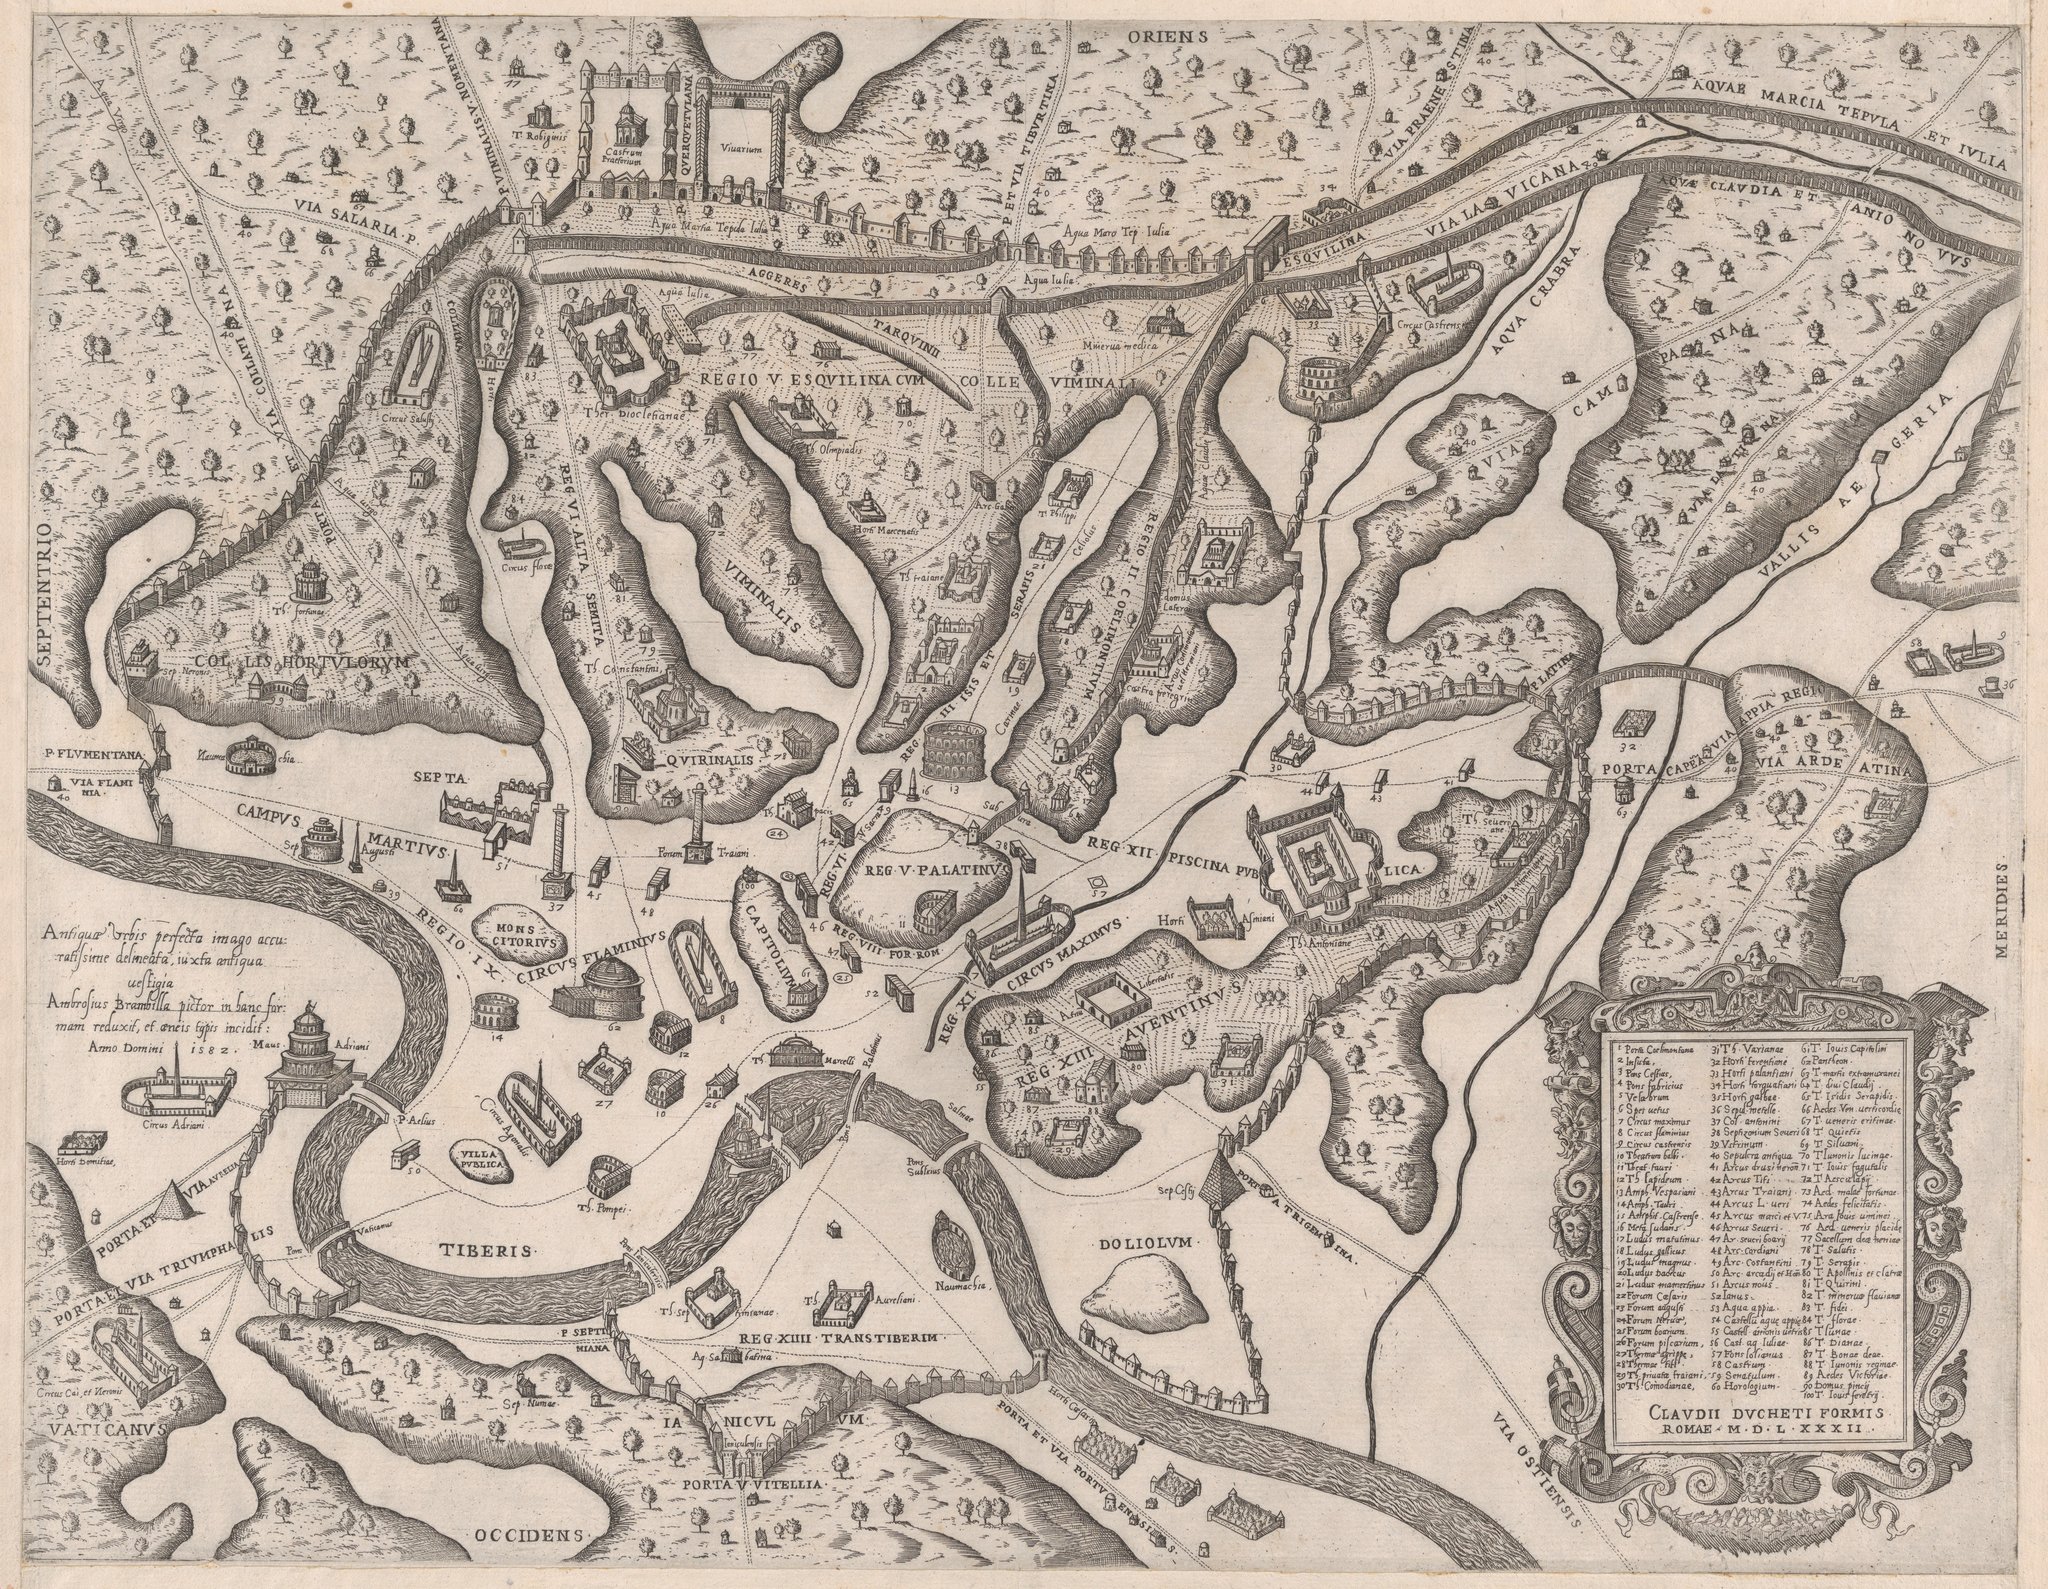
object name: print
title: Ancient Rome, and its Hills, from the West, from "Speculum Romanae Magnificentiae"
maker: giovanni ambrogio brambilla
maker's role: artist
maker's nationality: italian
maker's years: 1575-1599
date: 1582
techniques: etching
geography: rome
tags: maps,rome